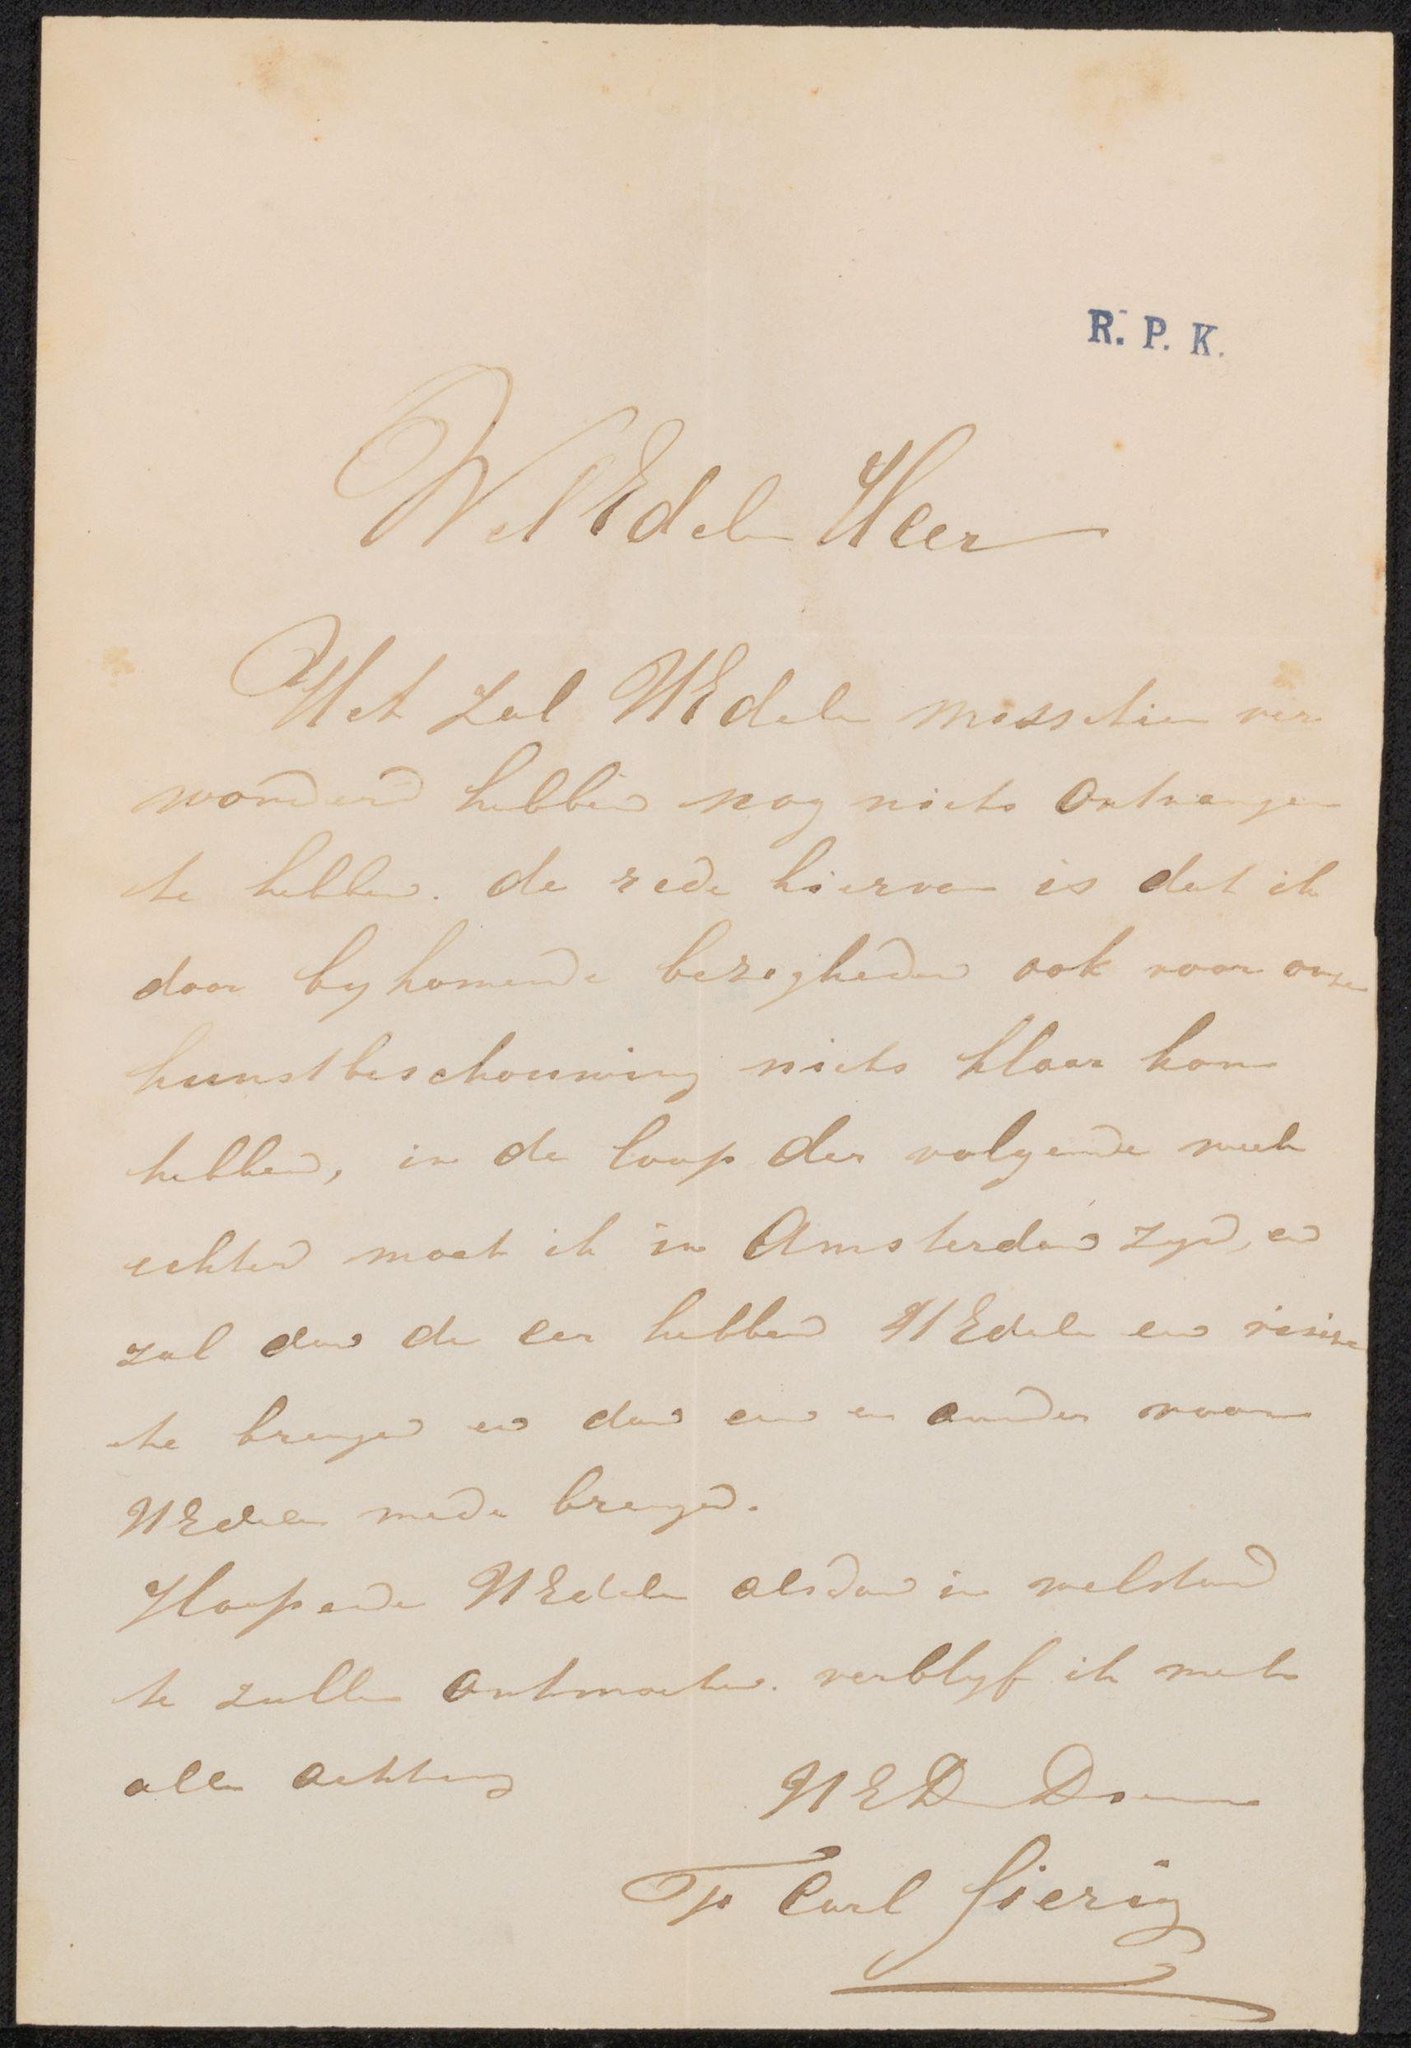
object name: letter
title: Brief aan Frans Buffa en Zonen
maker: ferdinand carl sierich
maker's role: draughtsman, painter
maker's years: 1839-1905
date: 1849-1905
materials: ink, paper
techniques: pen, writing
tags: publisher, criticizing and discussing art, art criticism, amsterdam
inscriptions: collector's mark: Lugt 2233